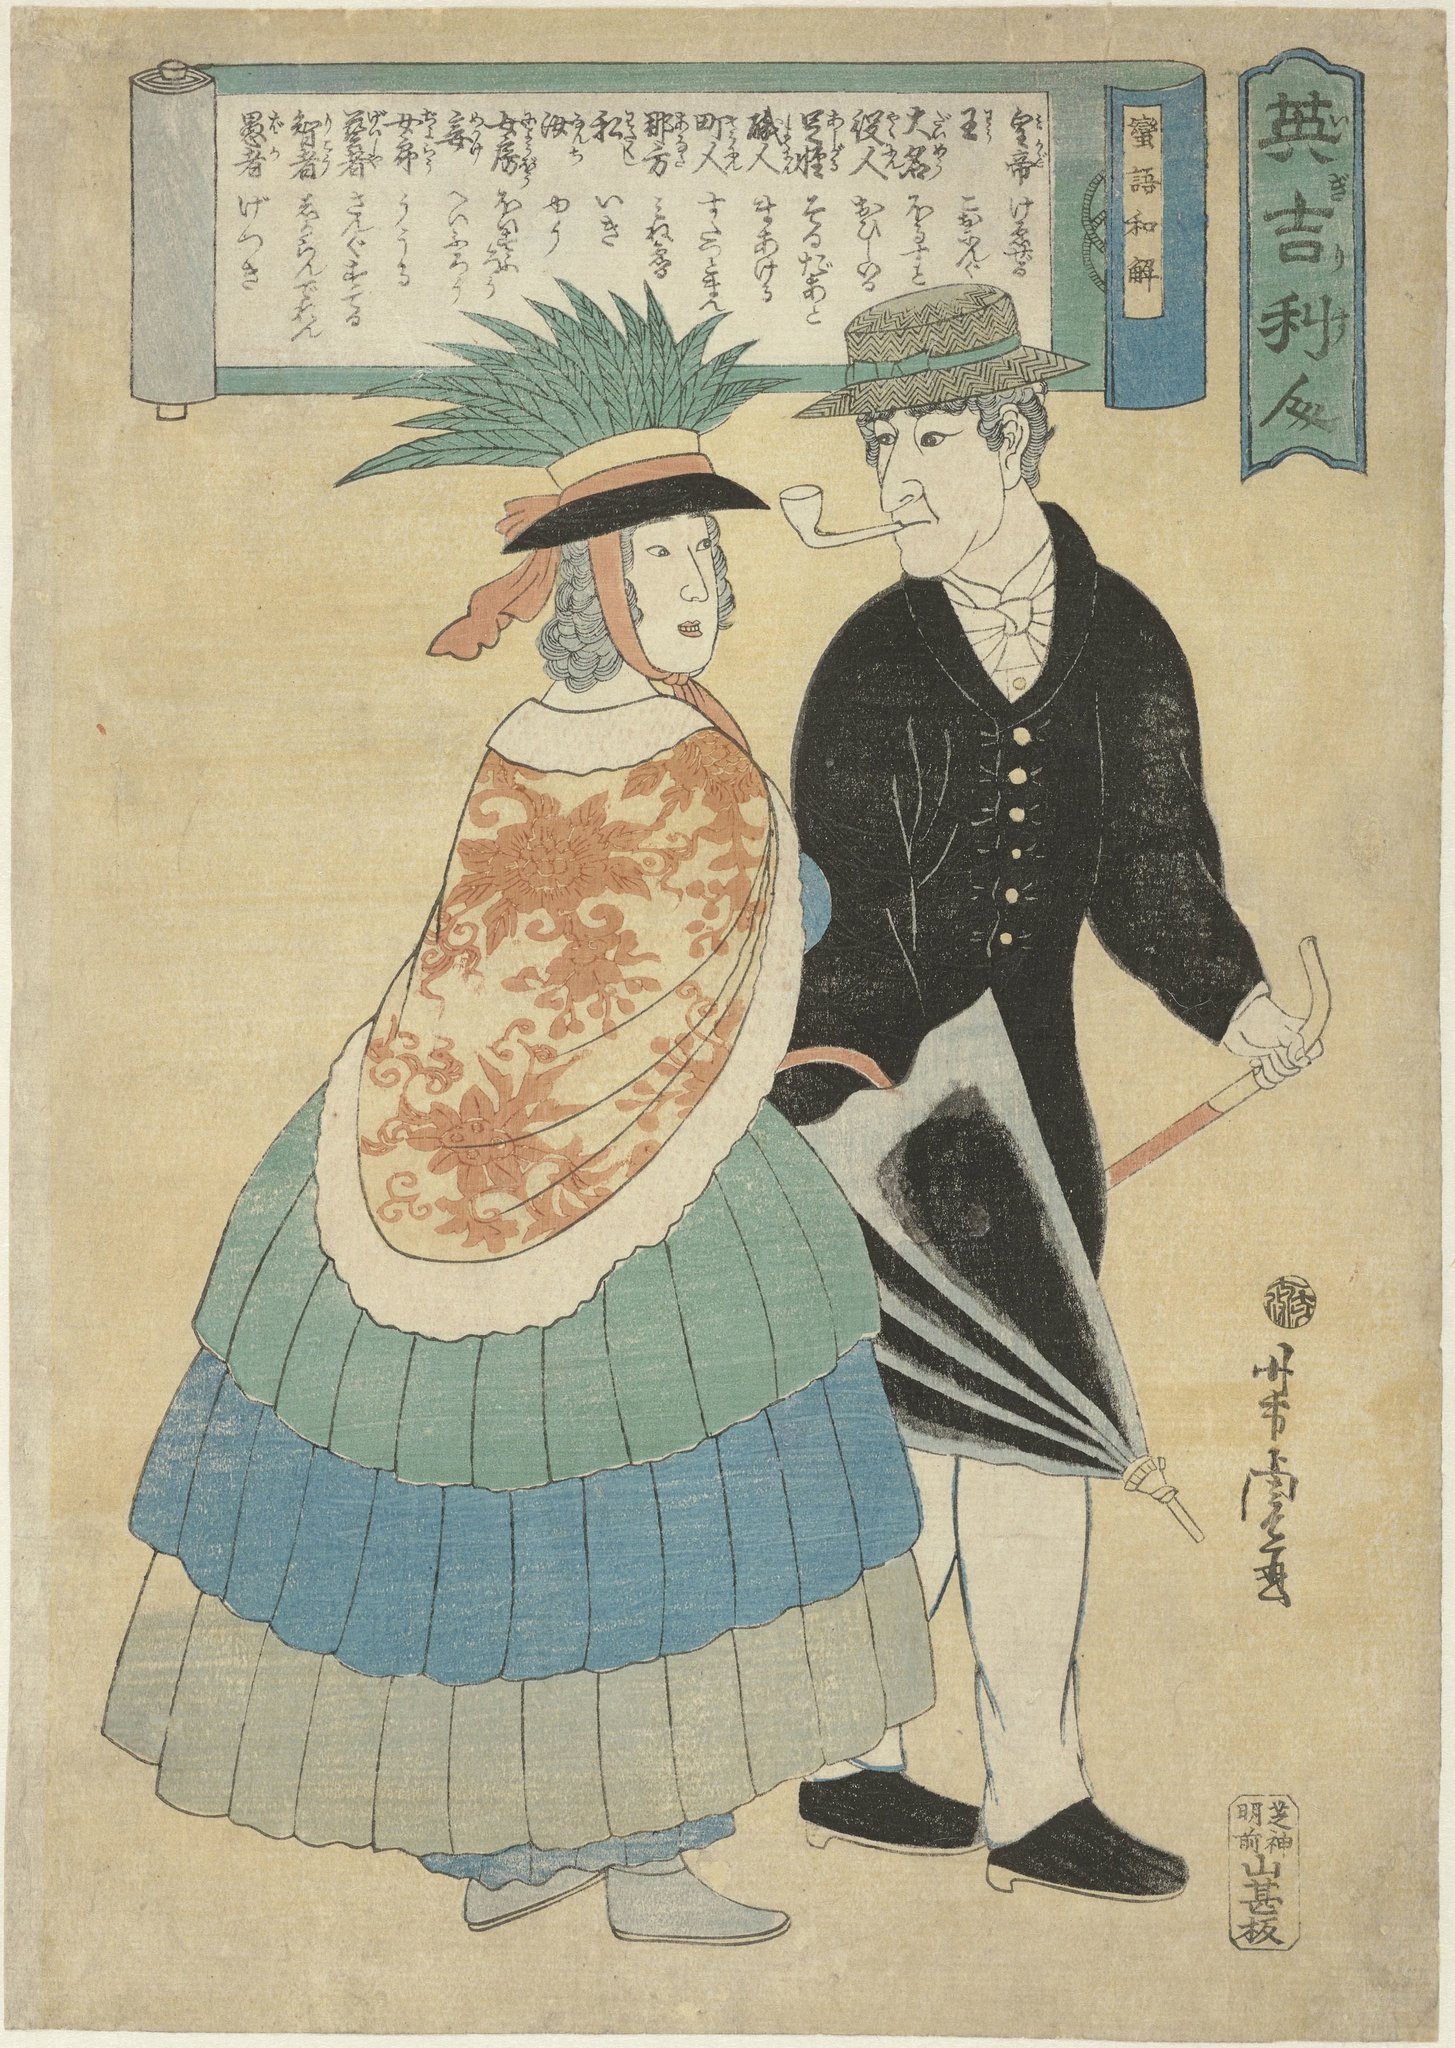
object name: print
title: Engels stel met pijp en paraplu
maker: utagawa yoshitora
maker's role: print maker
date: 1807-1863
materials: paper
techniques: woodcut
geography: japan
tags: europeans: englishmen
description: Engelse vrouw met paraplu in haar hand en hoofddeksel met veren, staat gedraaid naar een man met een pijp in zijn mond en een wandelstok in zijn hand. Het handrol-vormige cartouche geeft (in het Japans) de Engelse uitpraak voor verschillende woorden. (Yokohama-e).